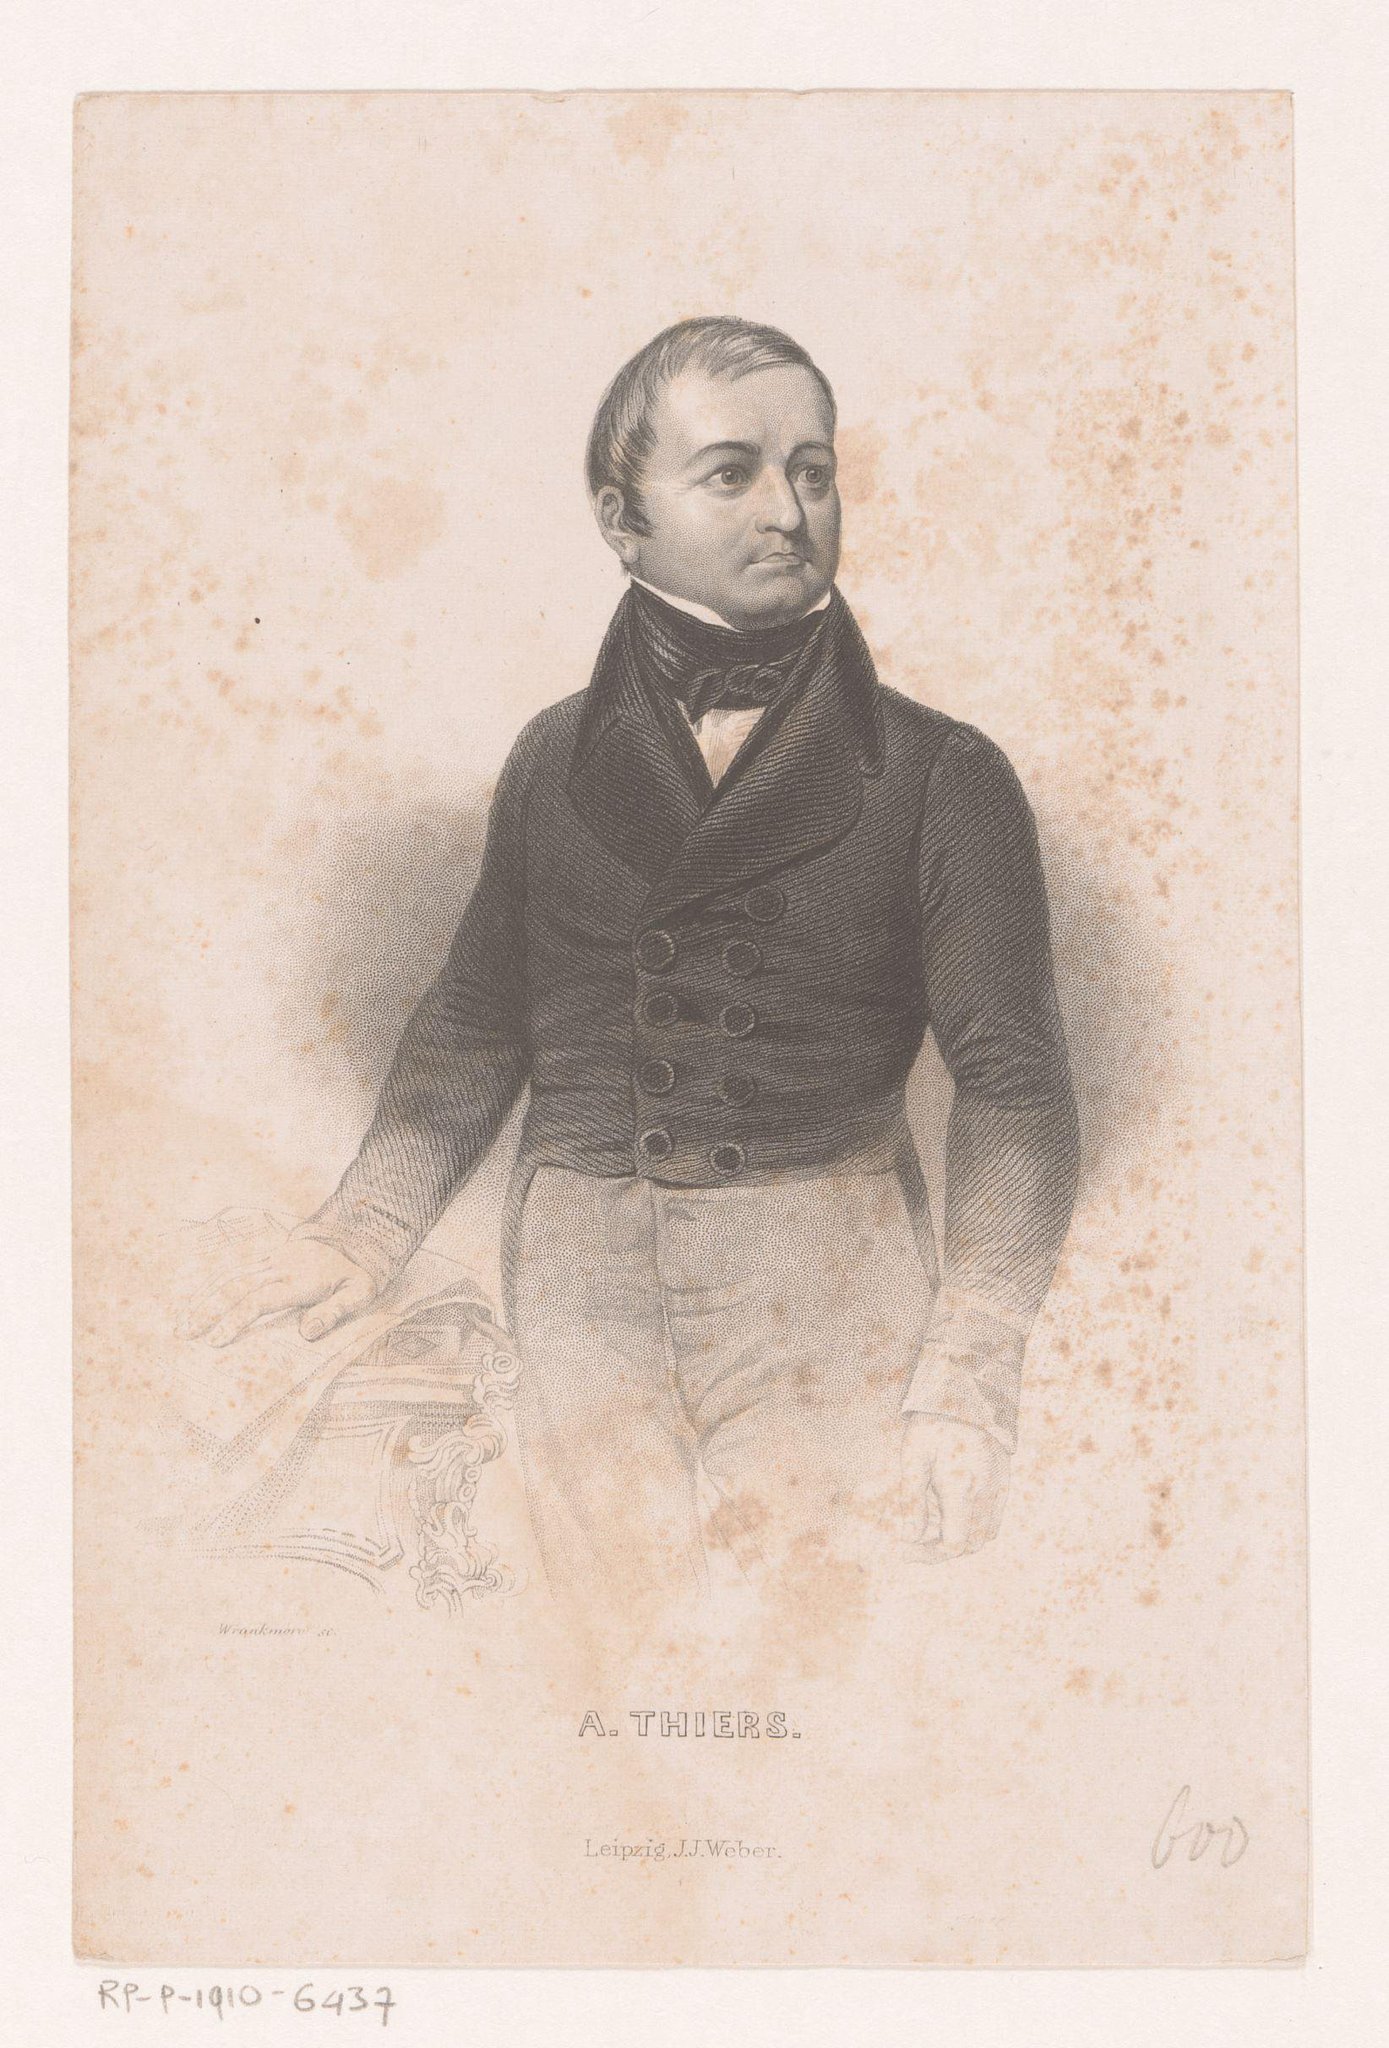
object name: print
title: Portret van Louis-Adolphe Thiers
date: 1826-1840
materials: paper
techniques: engraving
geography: leipzig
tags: marseille, politician, historical persons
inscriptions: collector's mark: Lugt 2228